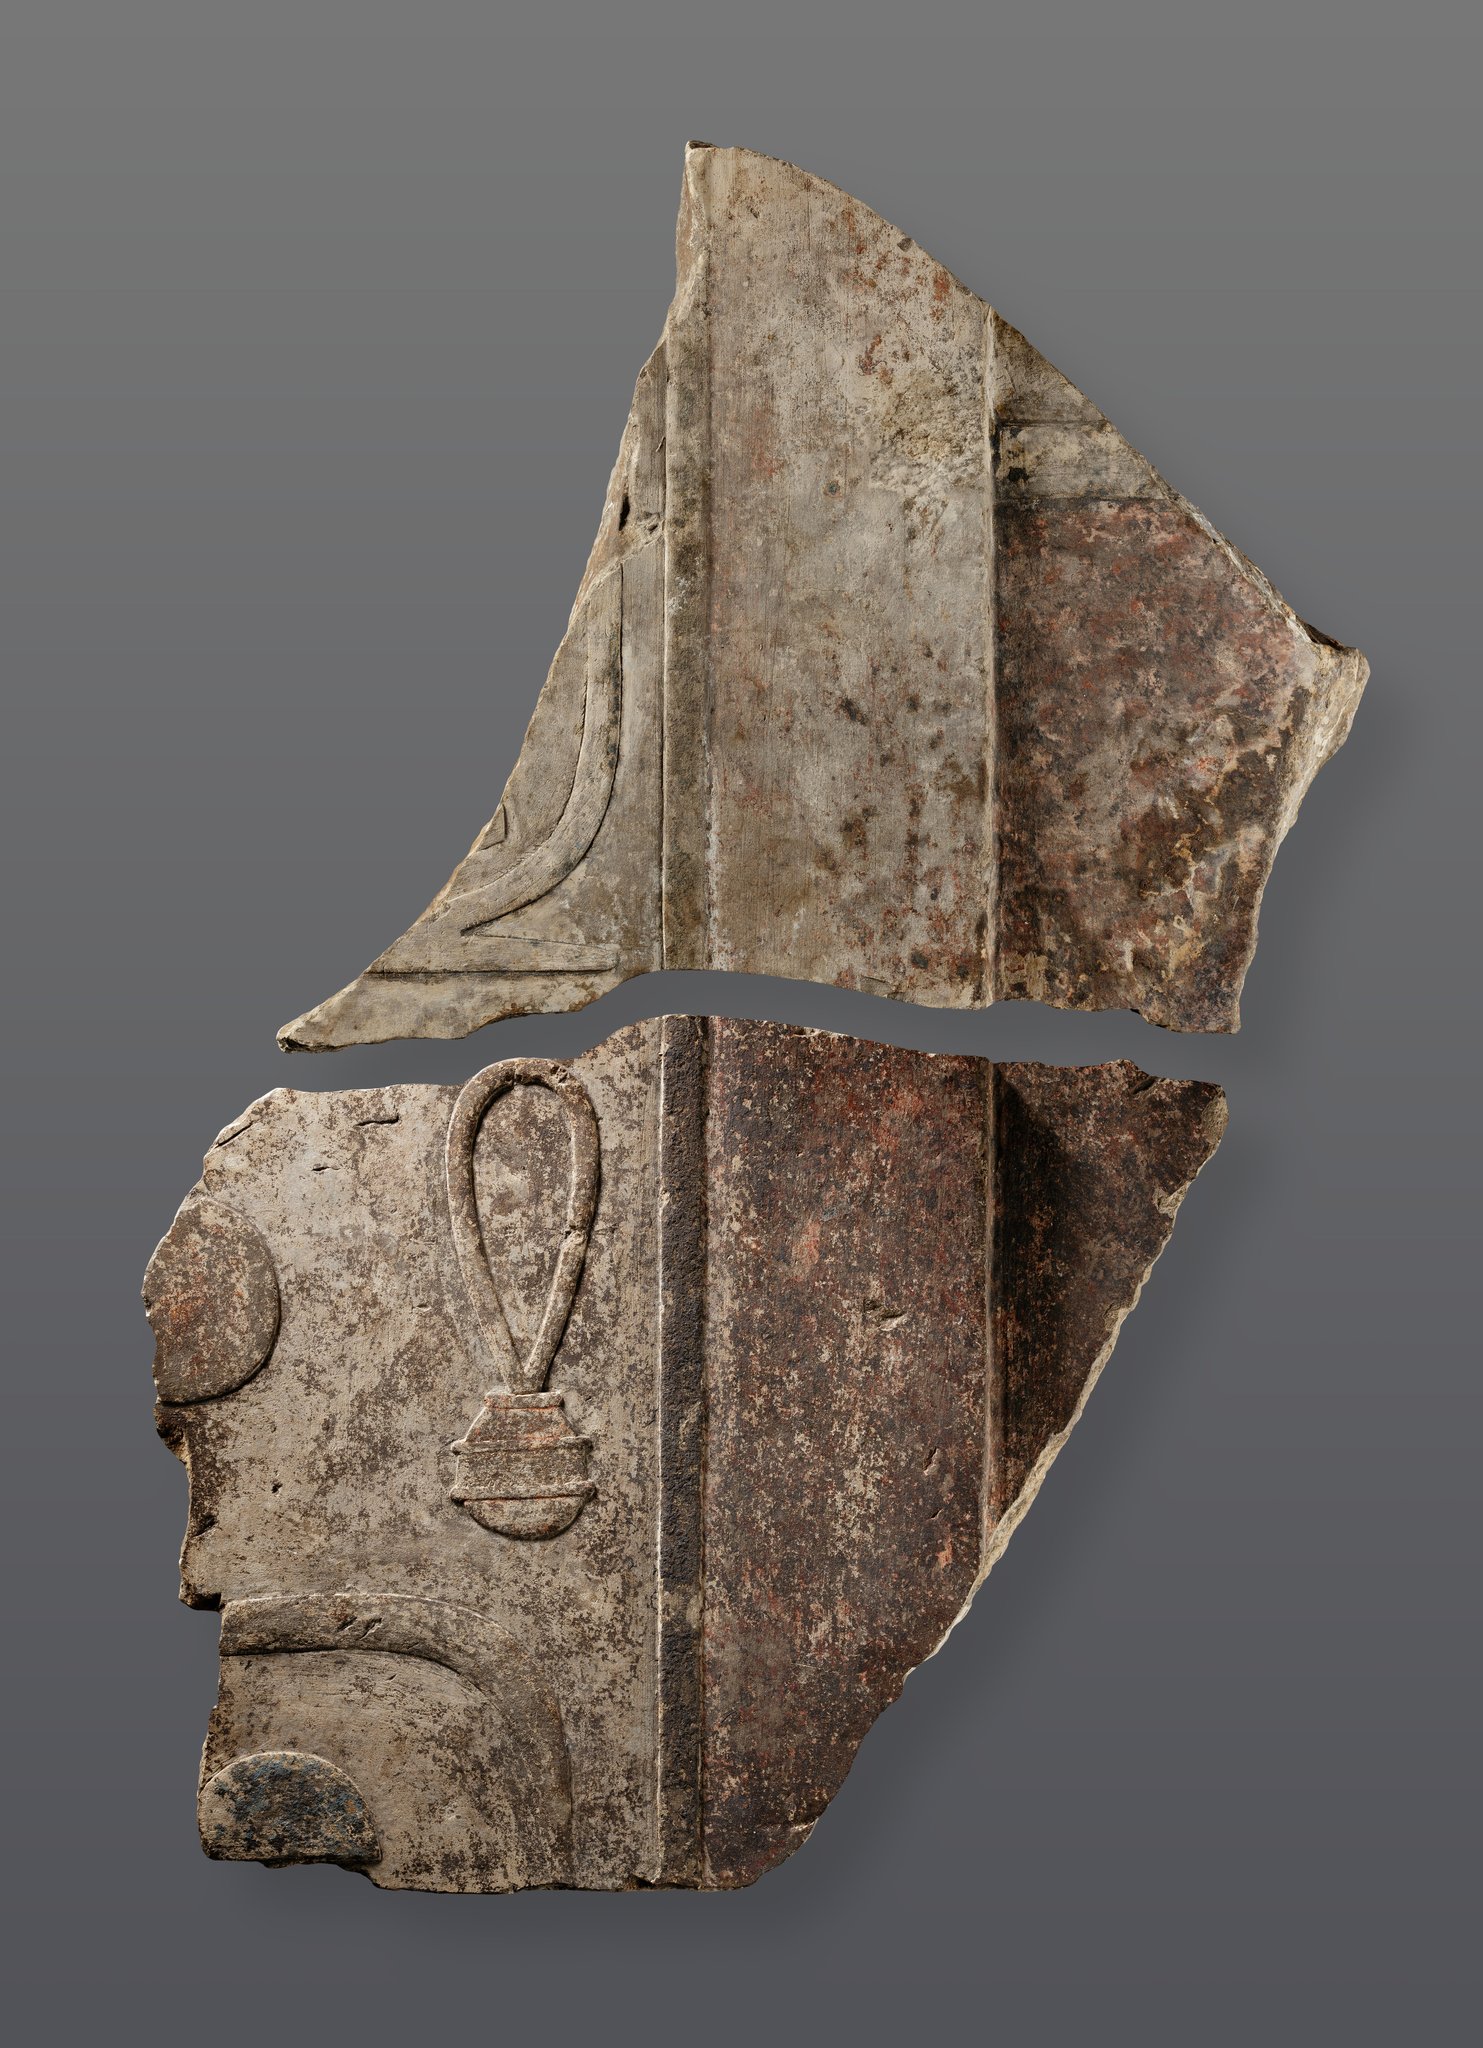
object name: relief fragment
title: Relief in 2 fragments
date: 1961-1917 BCE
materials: limestone, paint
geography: egypt